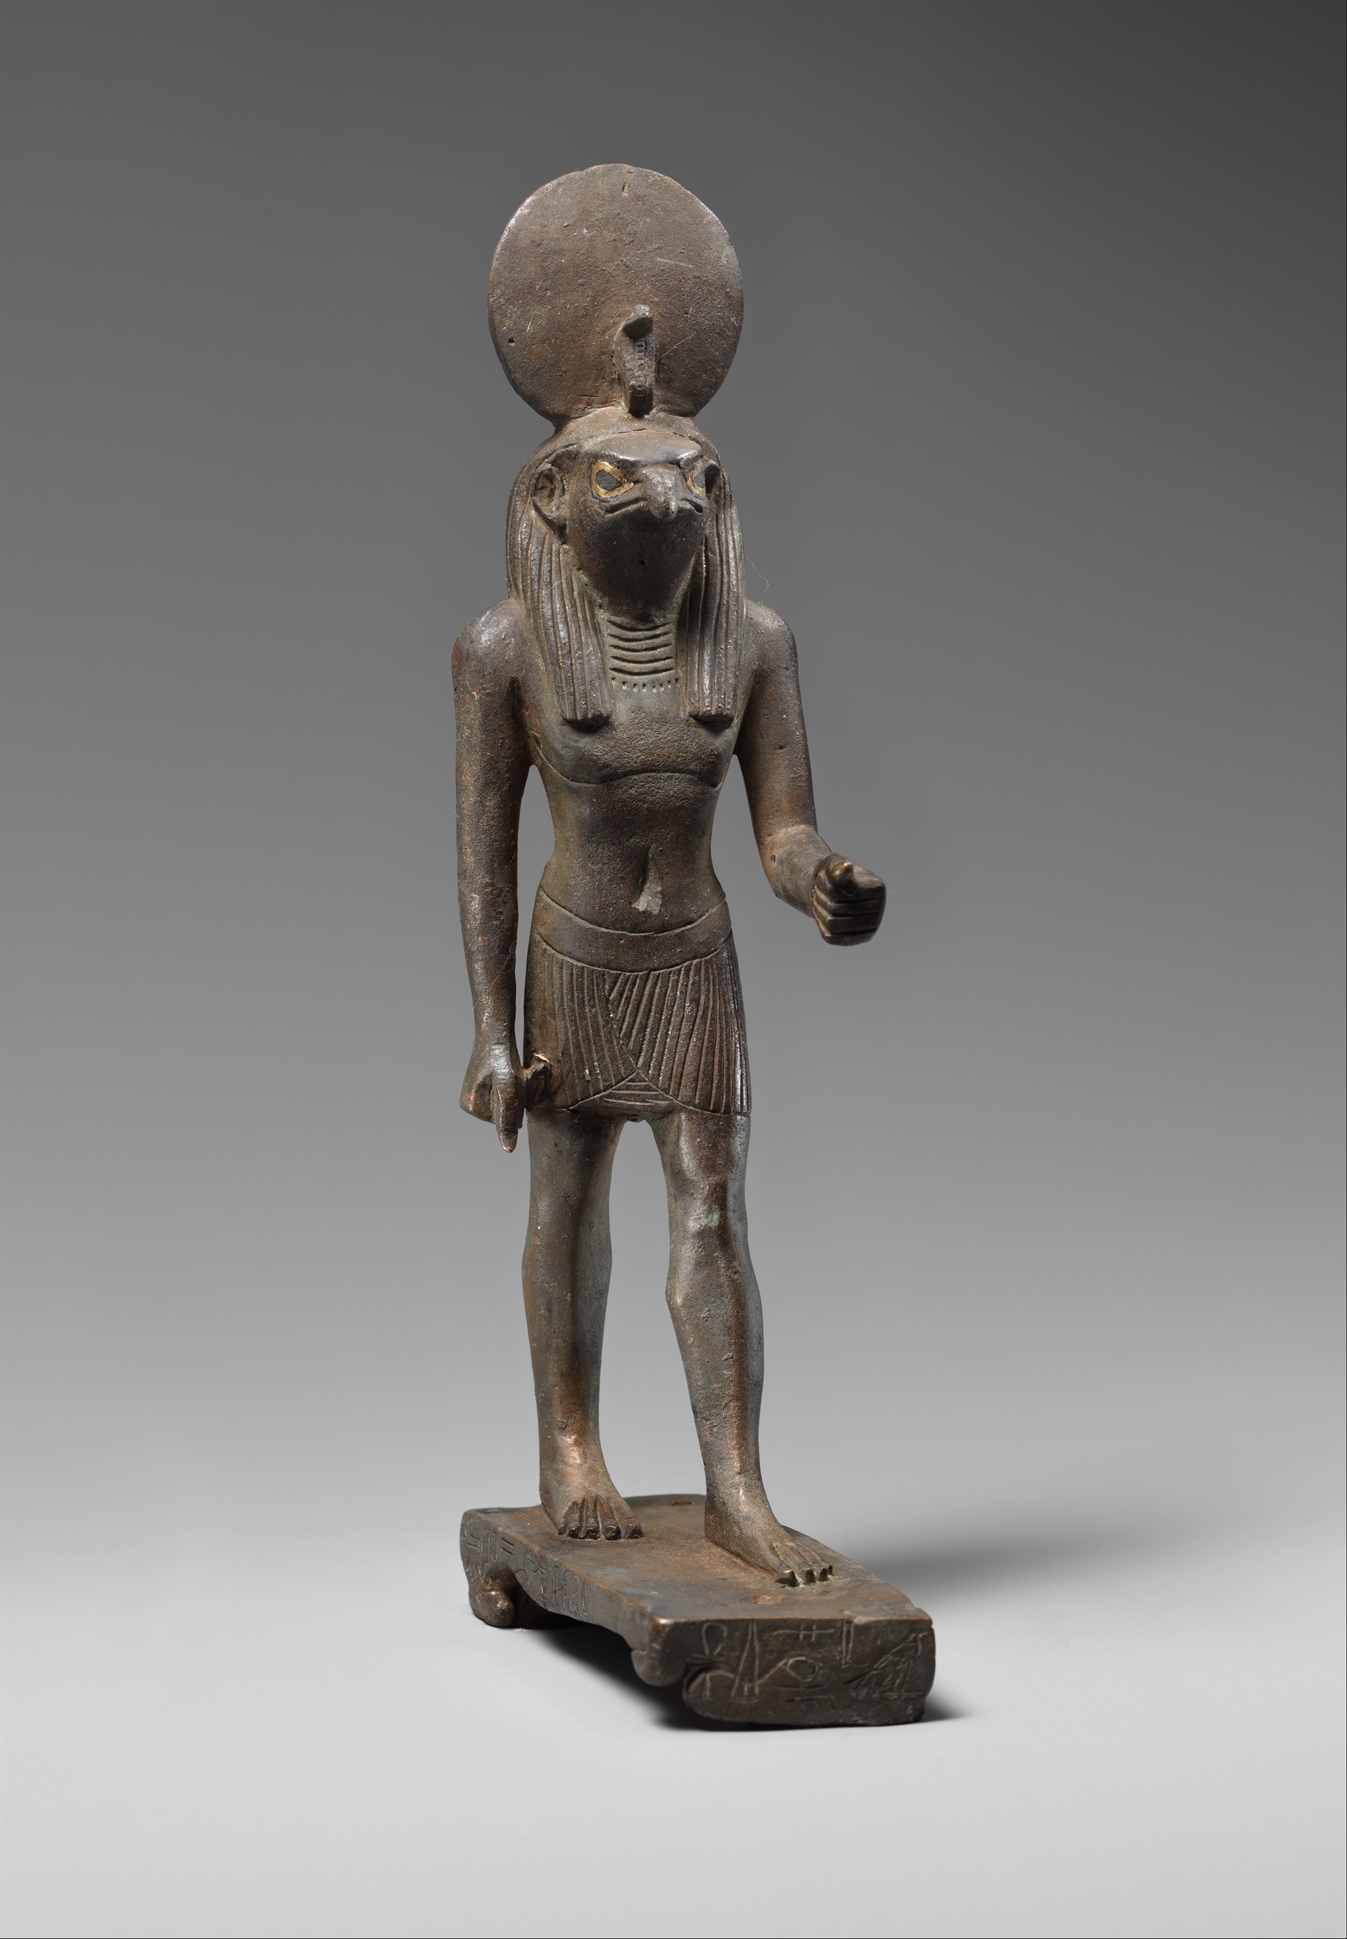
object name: statuette, horus, lord of sekhem letopolis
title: Statuette of Horus, lord of Sekhem (Letopolis)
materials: bronze, copper, gold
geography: egypt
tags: horus